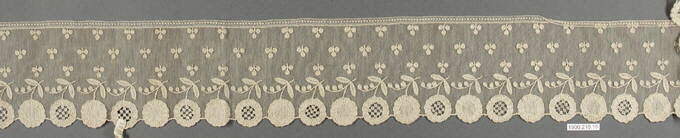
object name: edging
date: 1867-1900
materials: cotton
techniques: lace